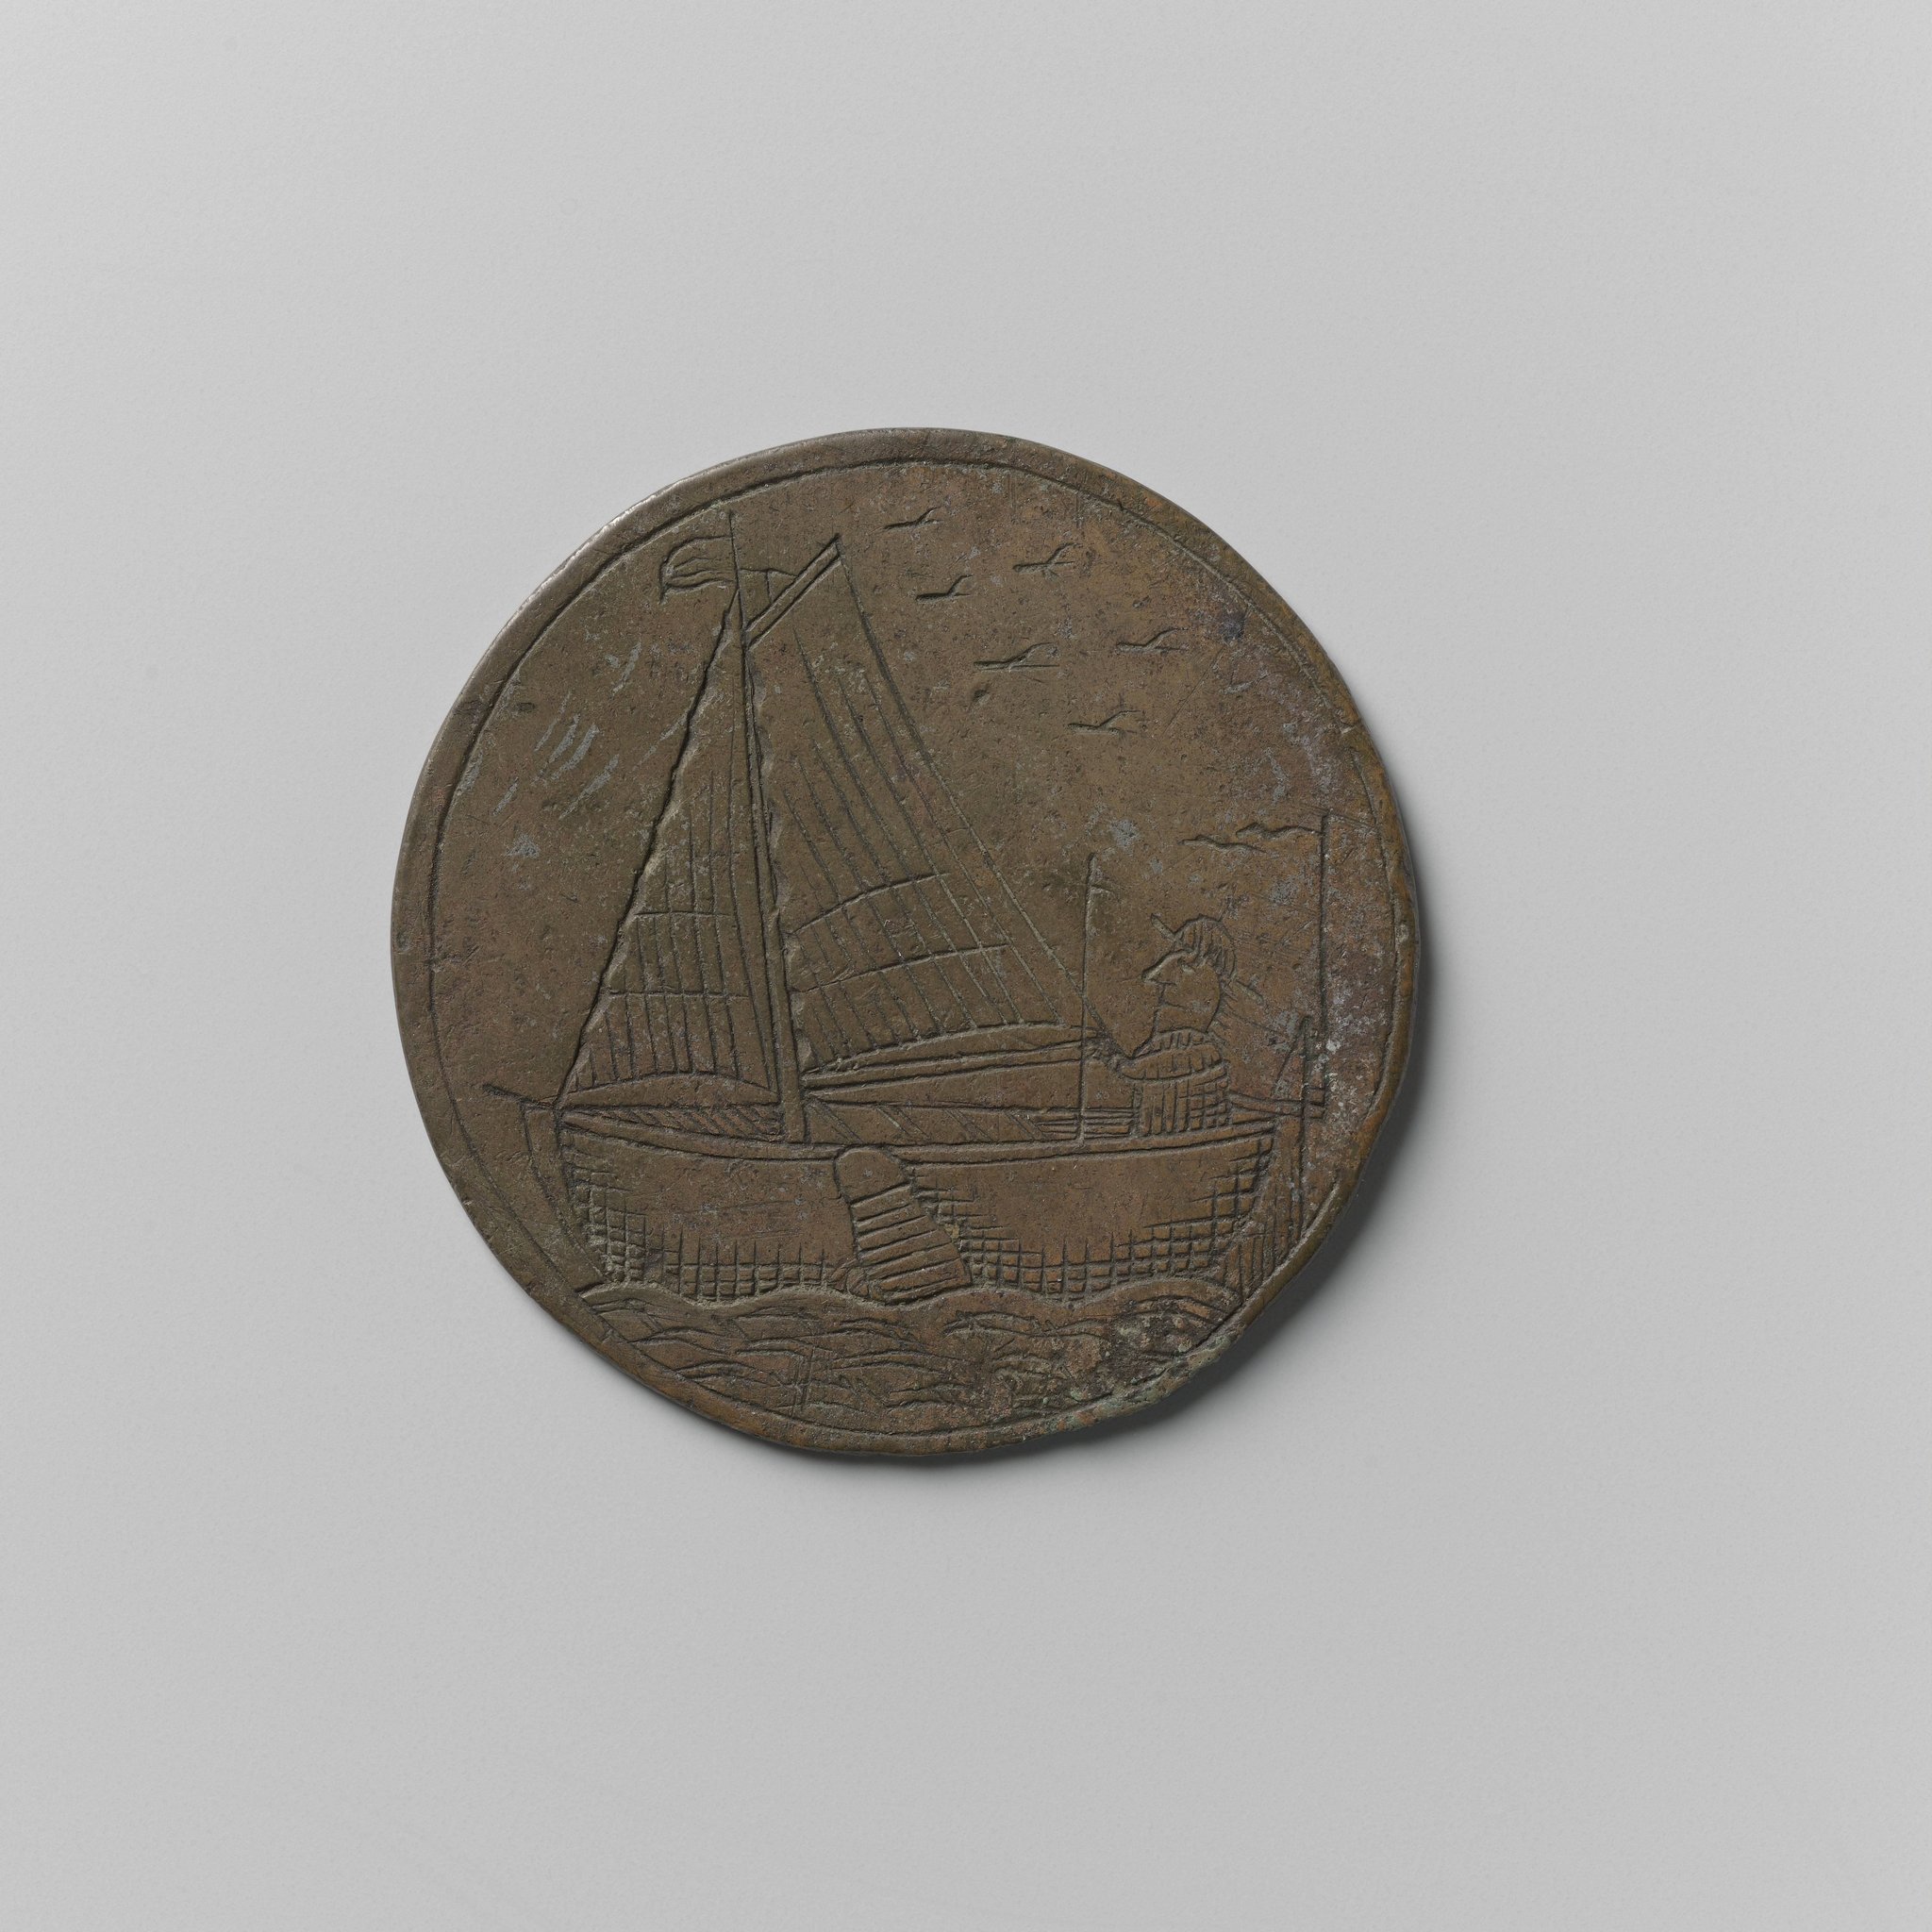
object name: medal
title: Roei-, steiger- en schuitenvoerdersgilde van Amsterdam, gildepenning van Pieter Wessens, ligplaats Kamper steiger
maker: Anonymous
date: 1761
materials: brass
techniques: engraving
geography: amsterdam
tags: amsterdam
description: Messing penning. Voorzijde: naar links varende zeilboot; op achterplecht: zittende man en vlag. Keerzijde: opschrift boven huismerk en hart met daarin letters P en W tussen monogram van letters K en S